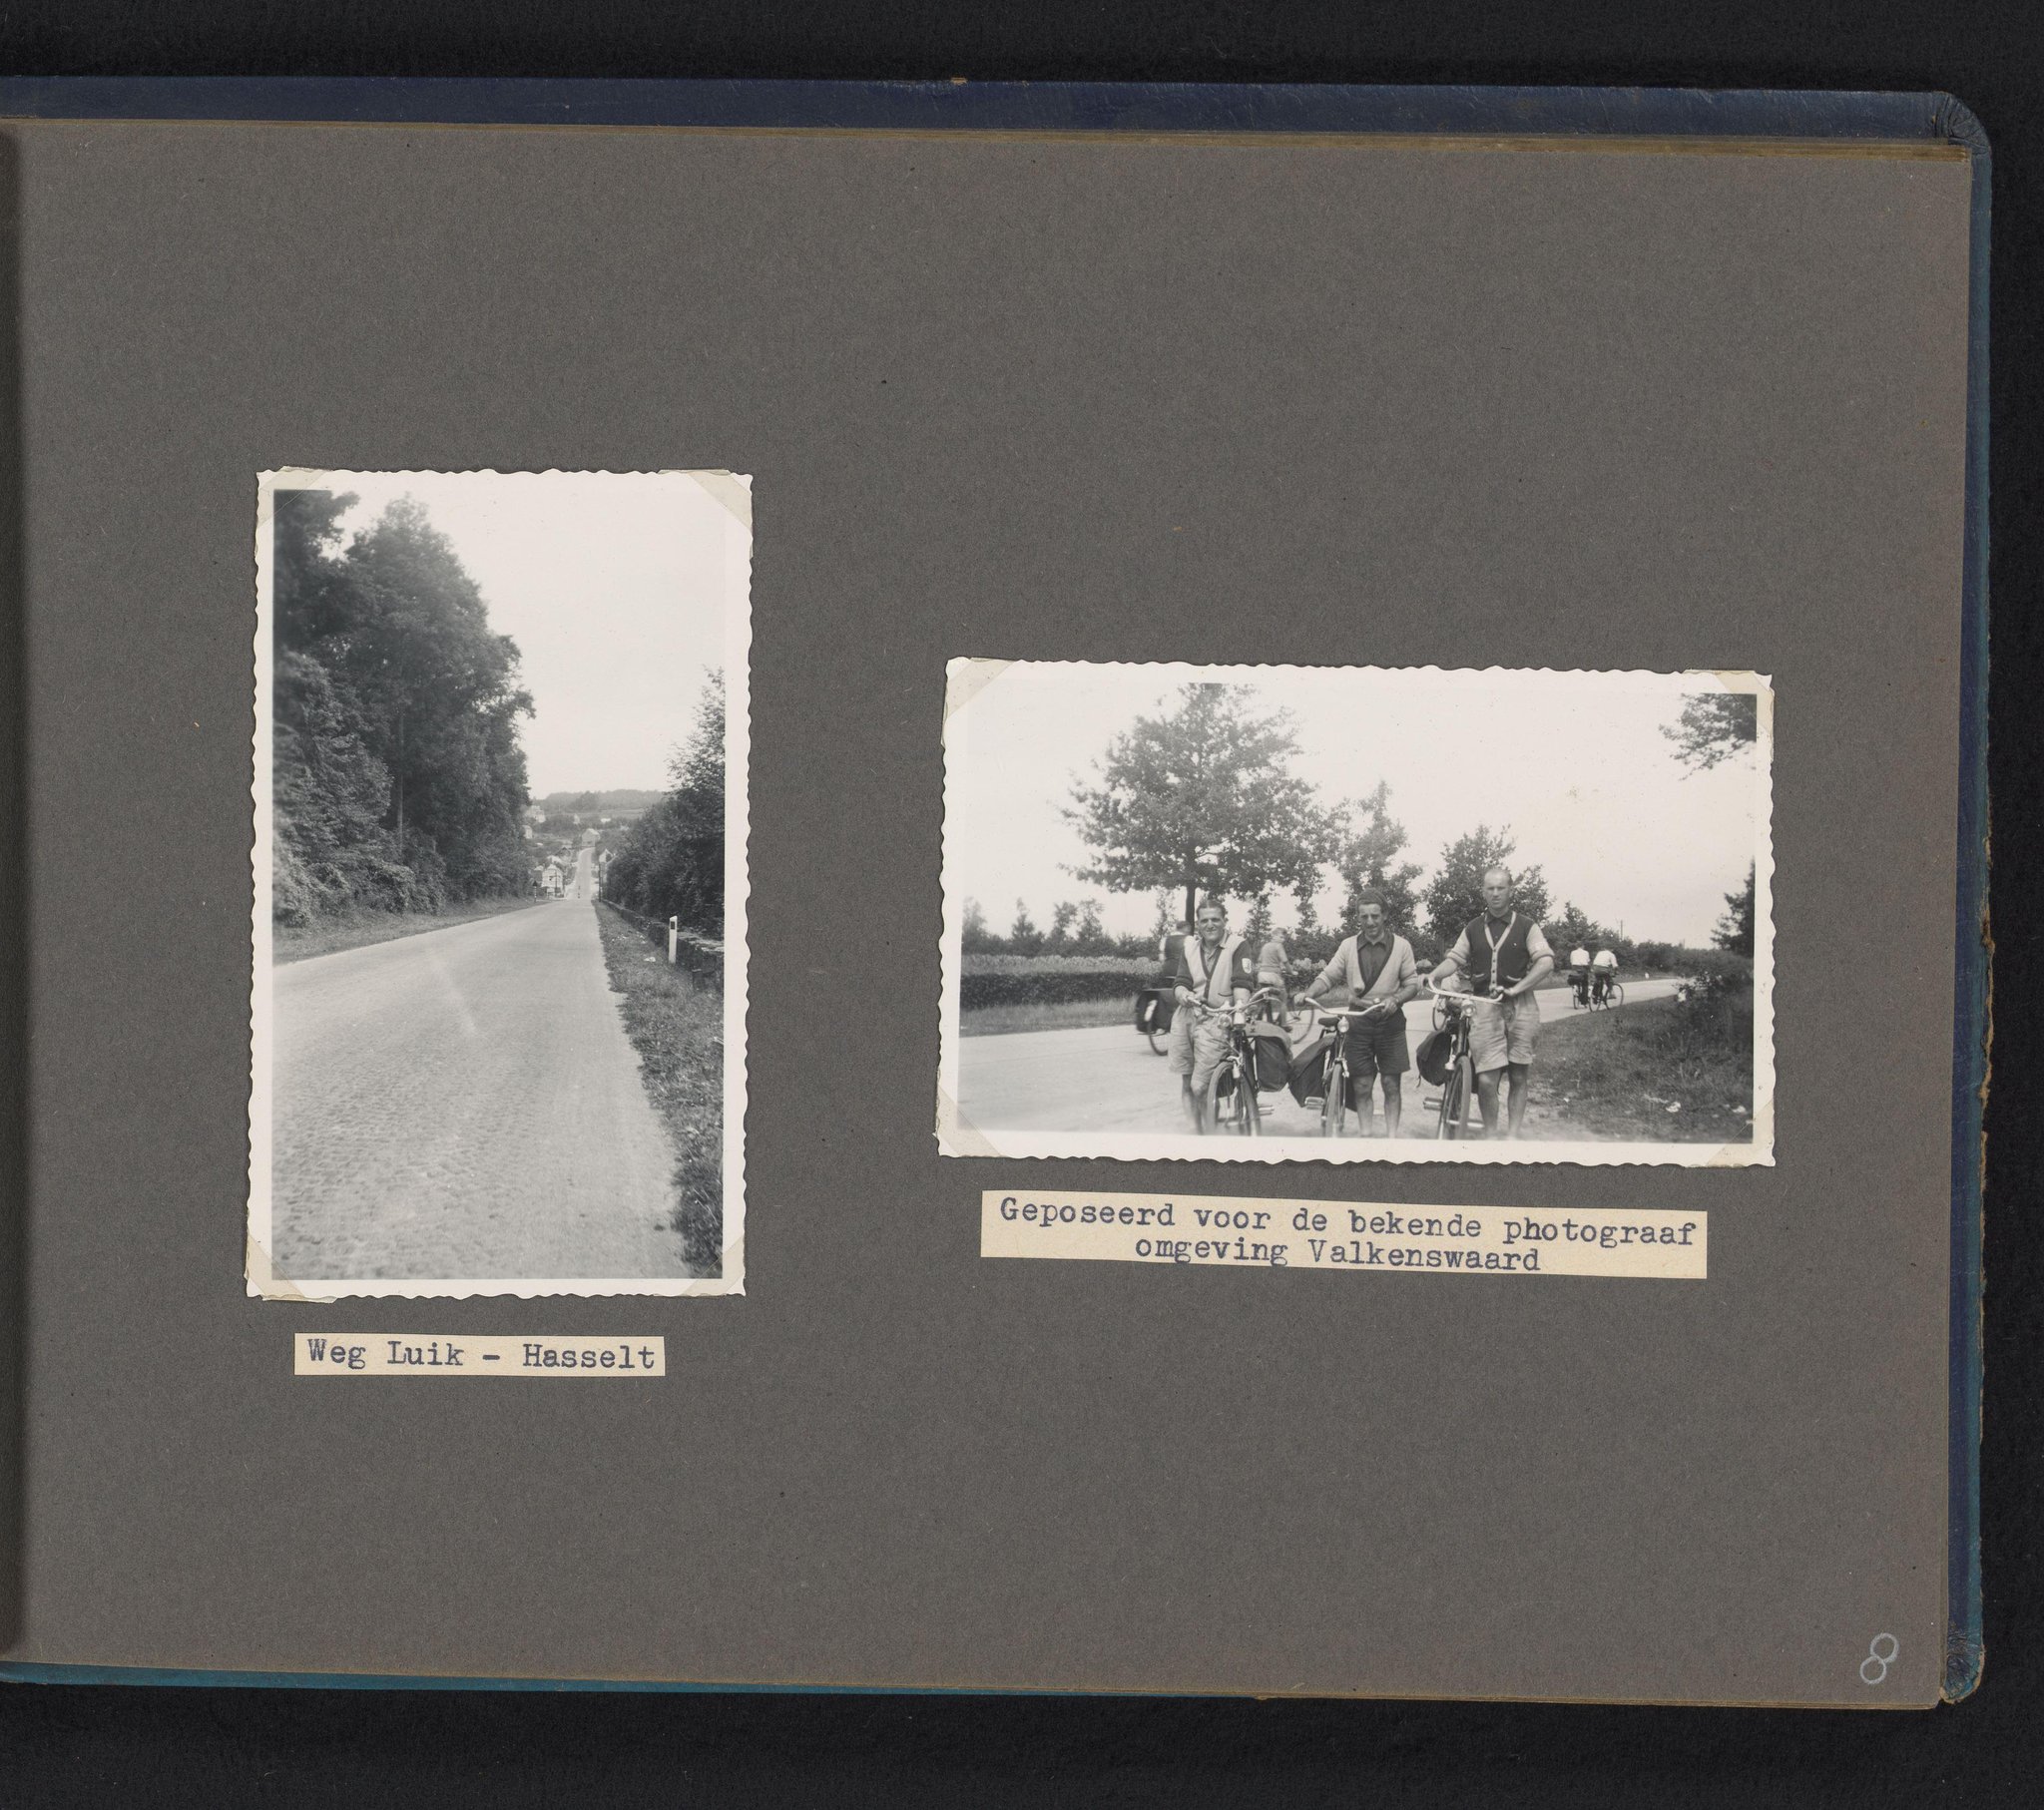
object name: album leaf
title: Fietsvakantie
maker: Anonymous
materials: paper, photographic support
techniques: gelatin silver print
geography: netherlands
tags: the family travelling, on holiday, riding, cycling (recreation), outing, pleasure trip, bicycle, netherlands, liège, belgium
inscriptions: inscription: ‘Weg Luik - Hasselt / Geposeerd voor de bekende photograaf omgeving Valkenswaard’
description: Albumblad met twee foto's genomen tijdens een fietsvakantie. Onder de foto's uitgeknipte papiertjes met getypte opschriften. Onderdeel van het derde fotoalbum met foto's van familievakanties in Nederland, België en Luxemburg in 1952-1953.